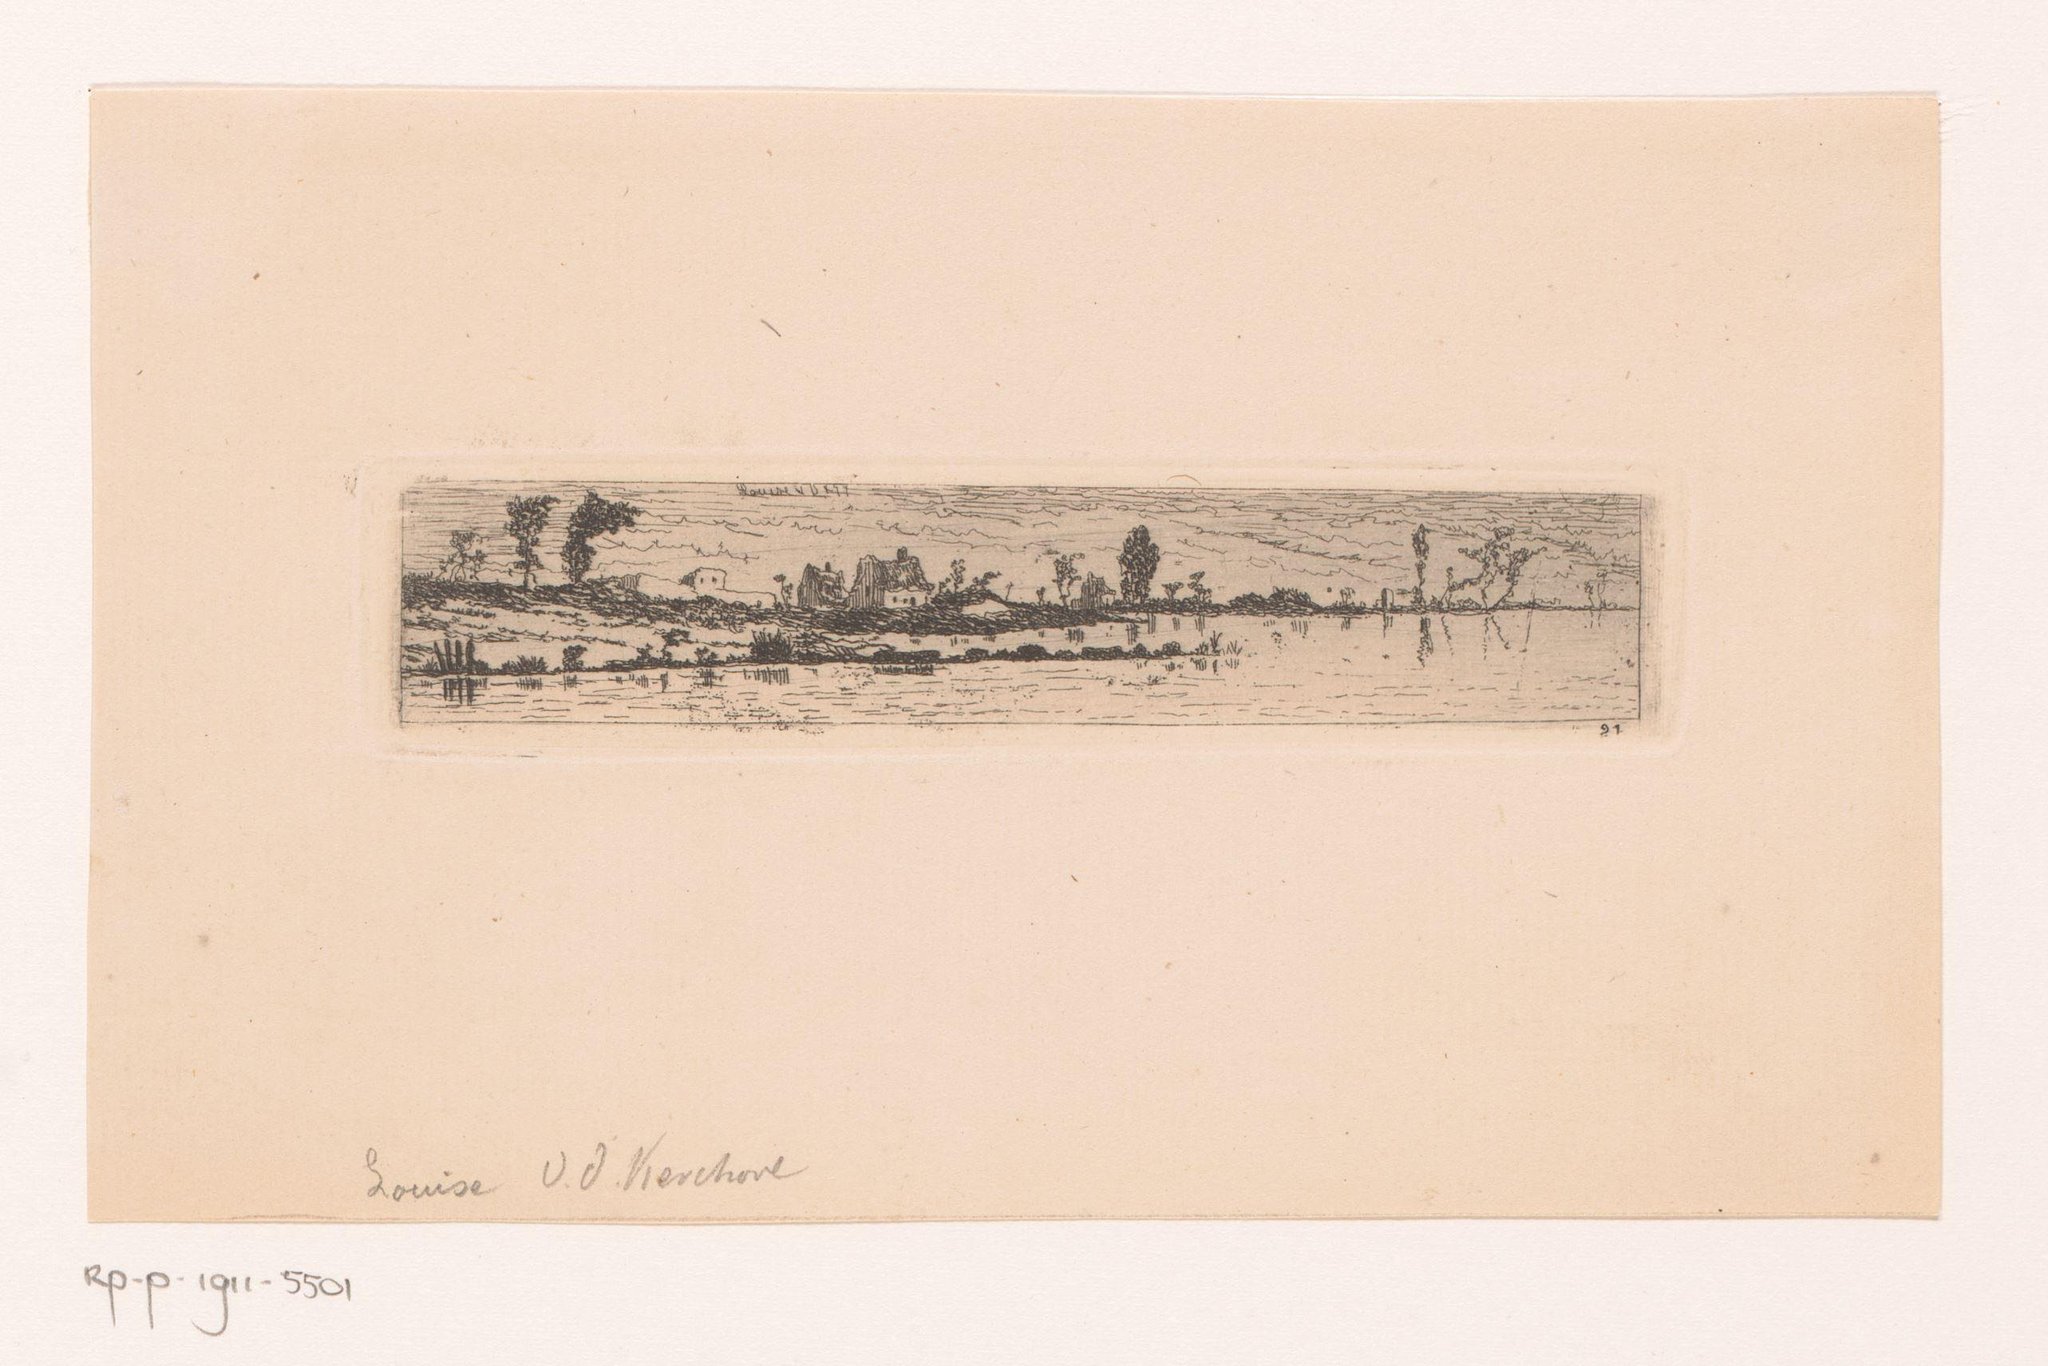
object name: print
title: Riviergezicht met huizen op de oever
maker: louise van de kerkhove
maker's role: print maker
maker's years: 1860-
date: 1877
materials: paper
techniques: etching, intaglio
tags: river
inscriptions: collector's mark: Lugt 2228